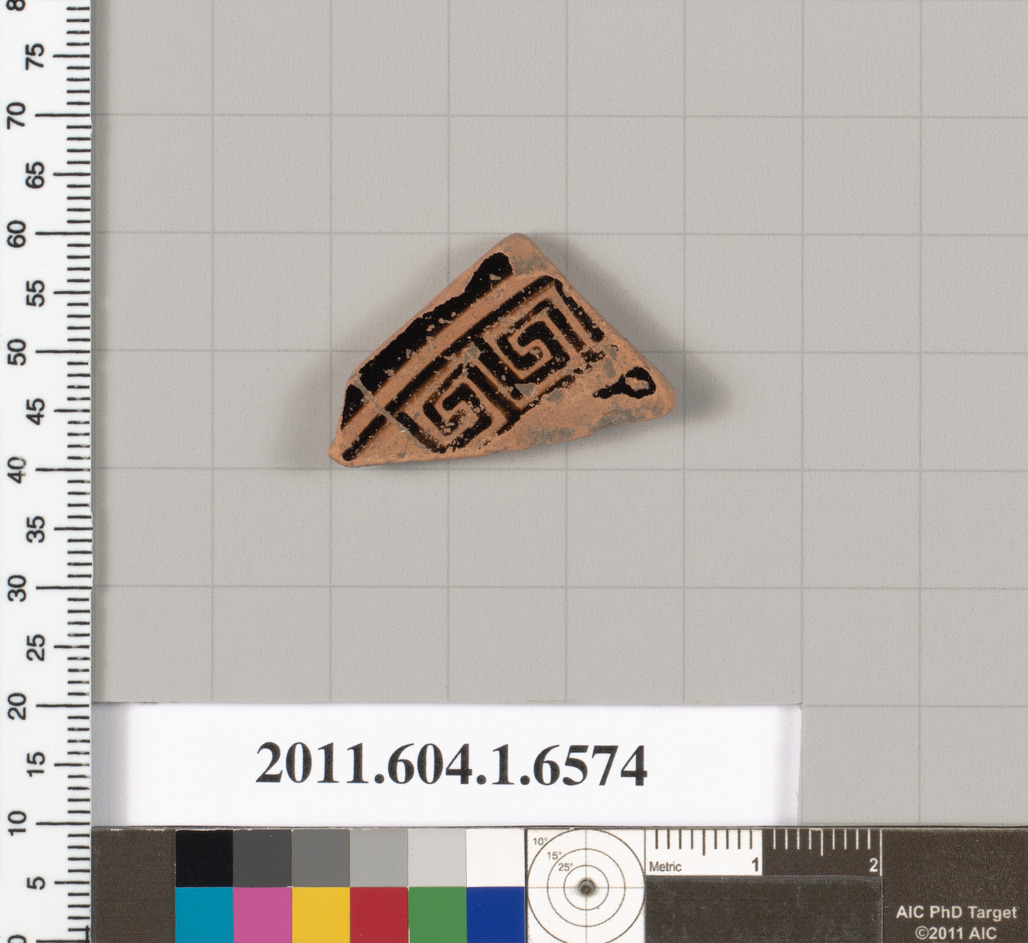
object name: kylix fragment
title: Terracotta fragment of a kylix (drinking cup)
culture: greek, attic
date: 490-480 BCE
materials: terracotta